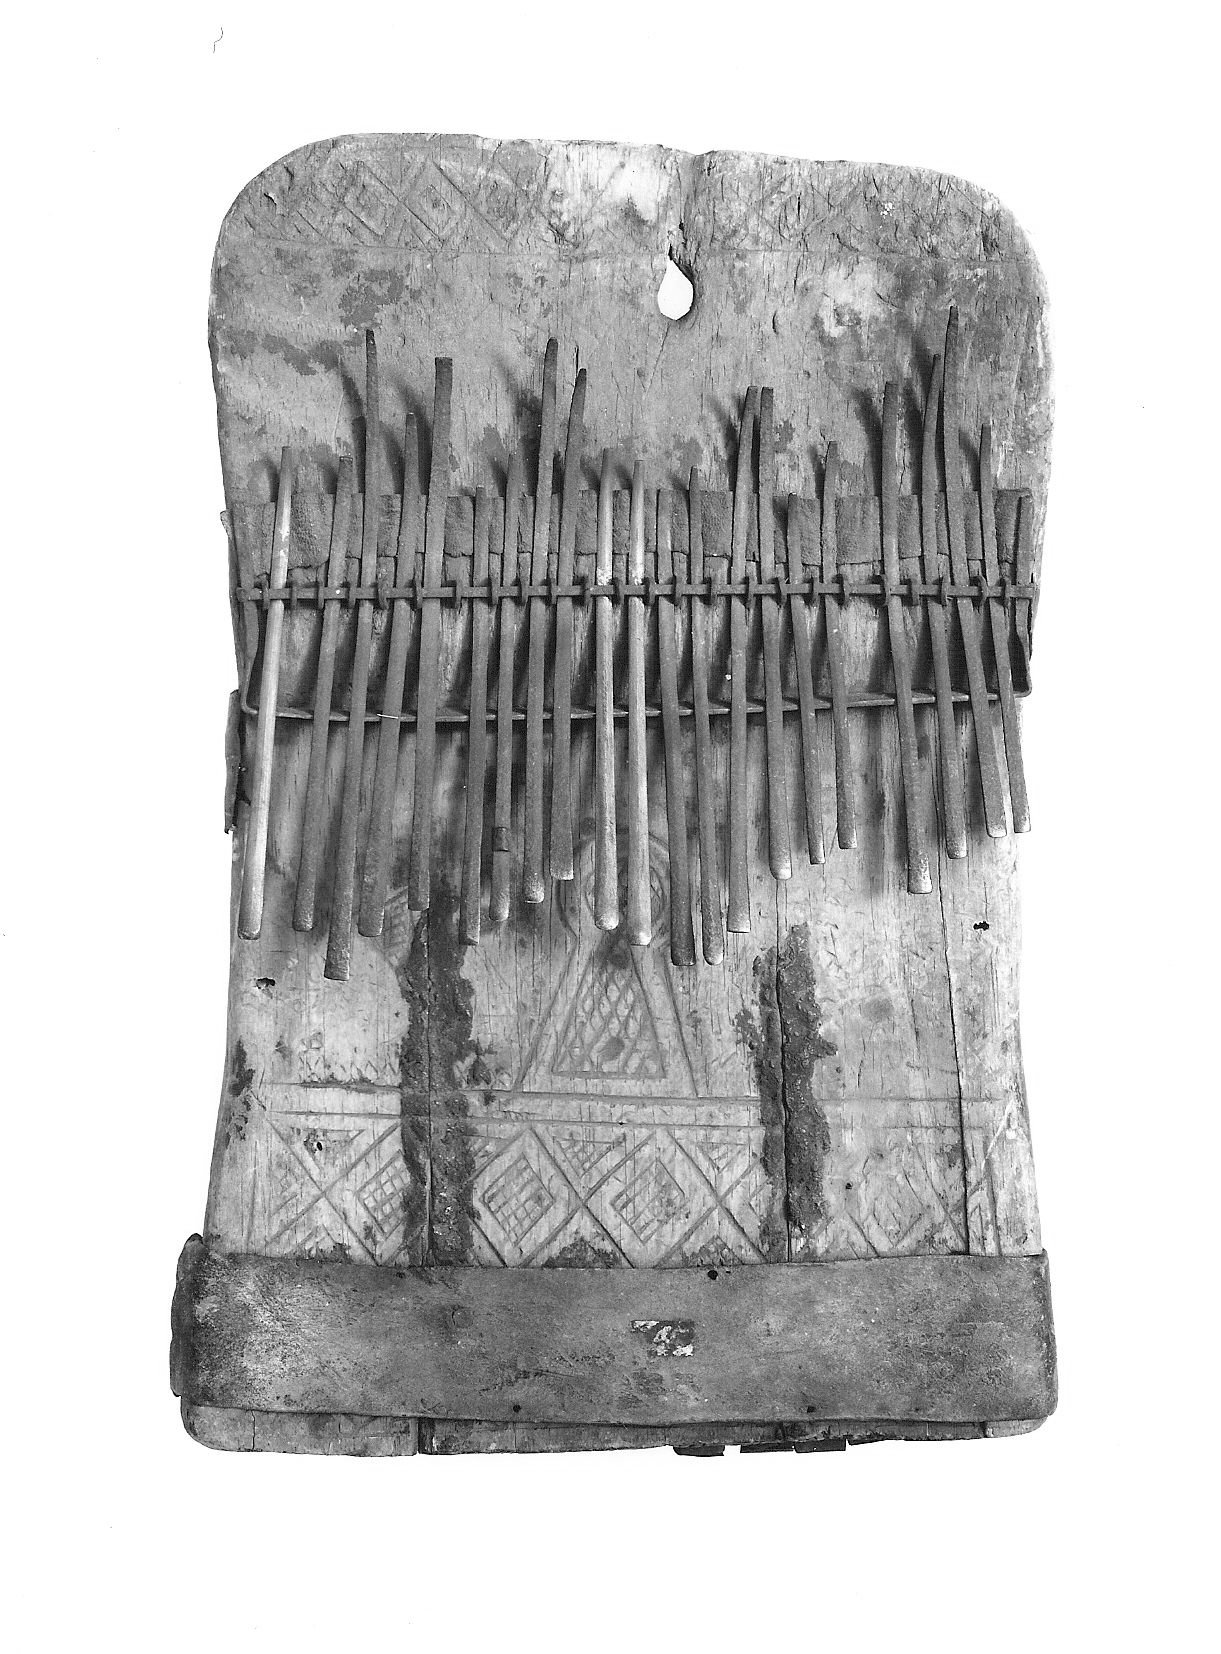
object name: zanze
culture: angolan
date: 1867-1900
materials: metal, wood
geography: angola